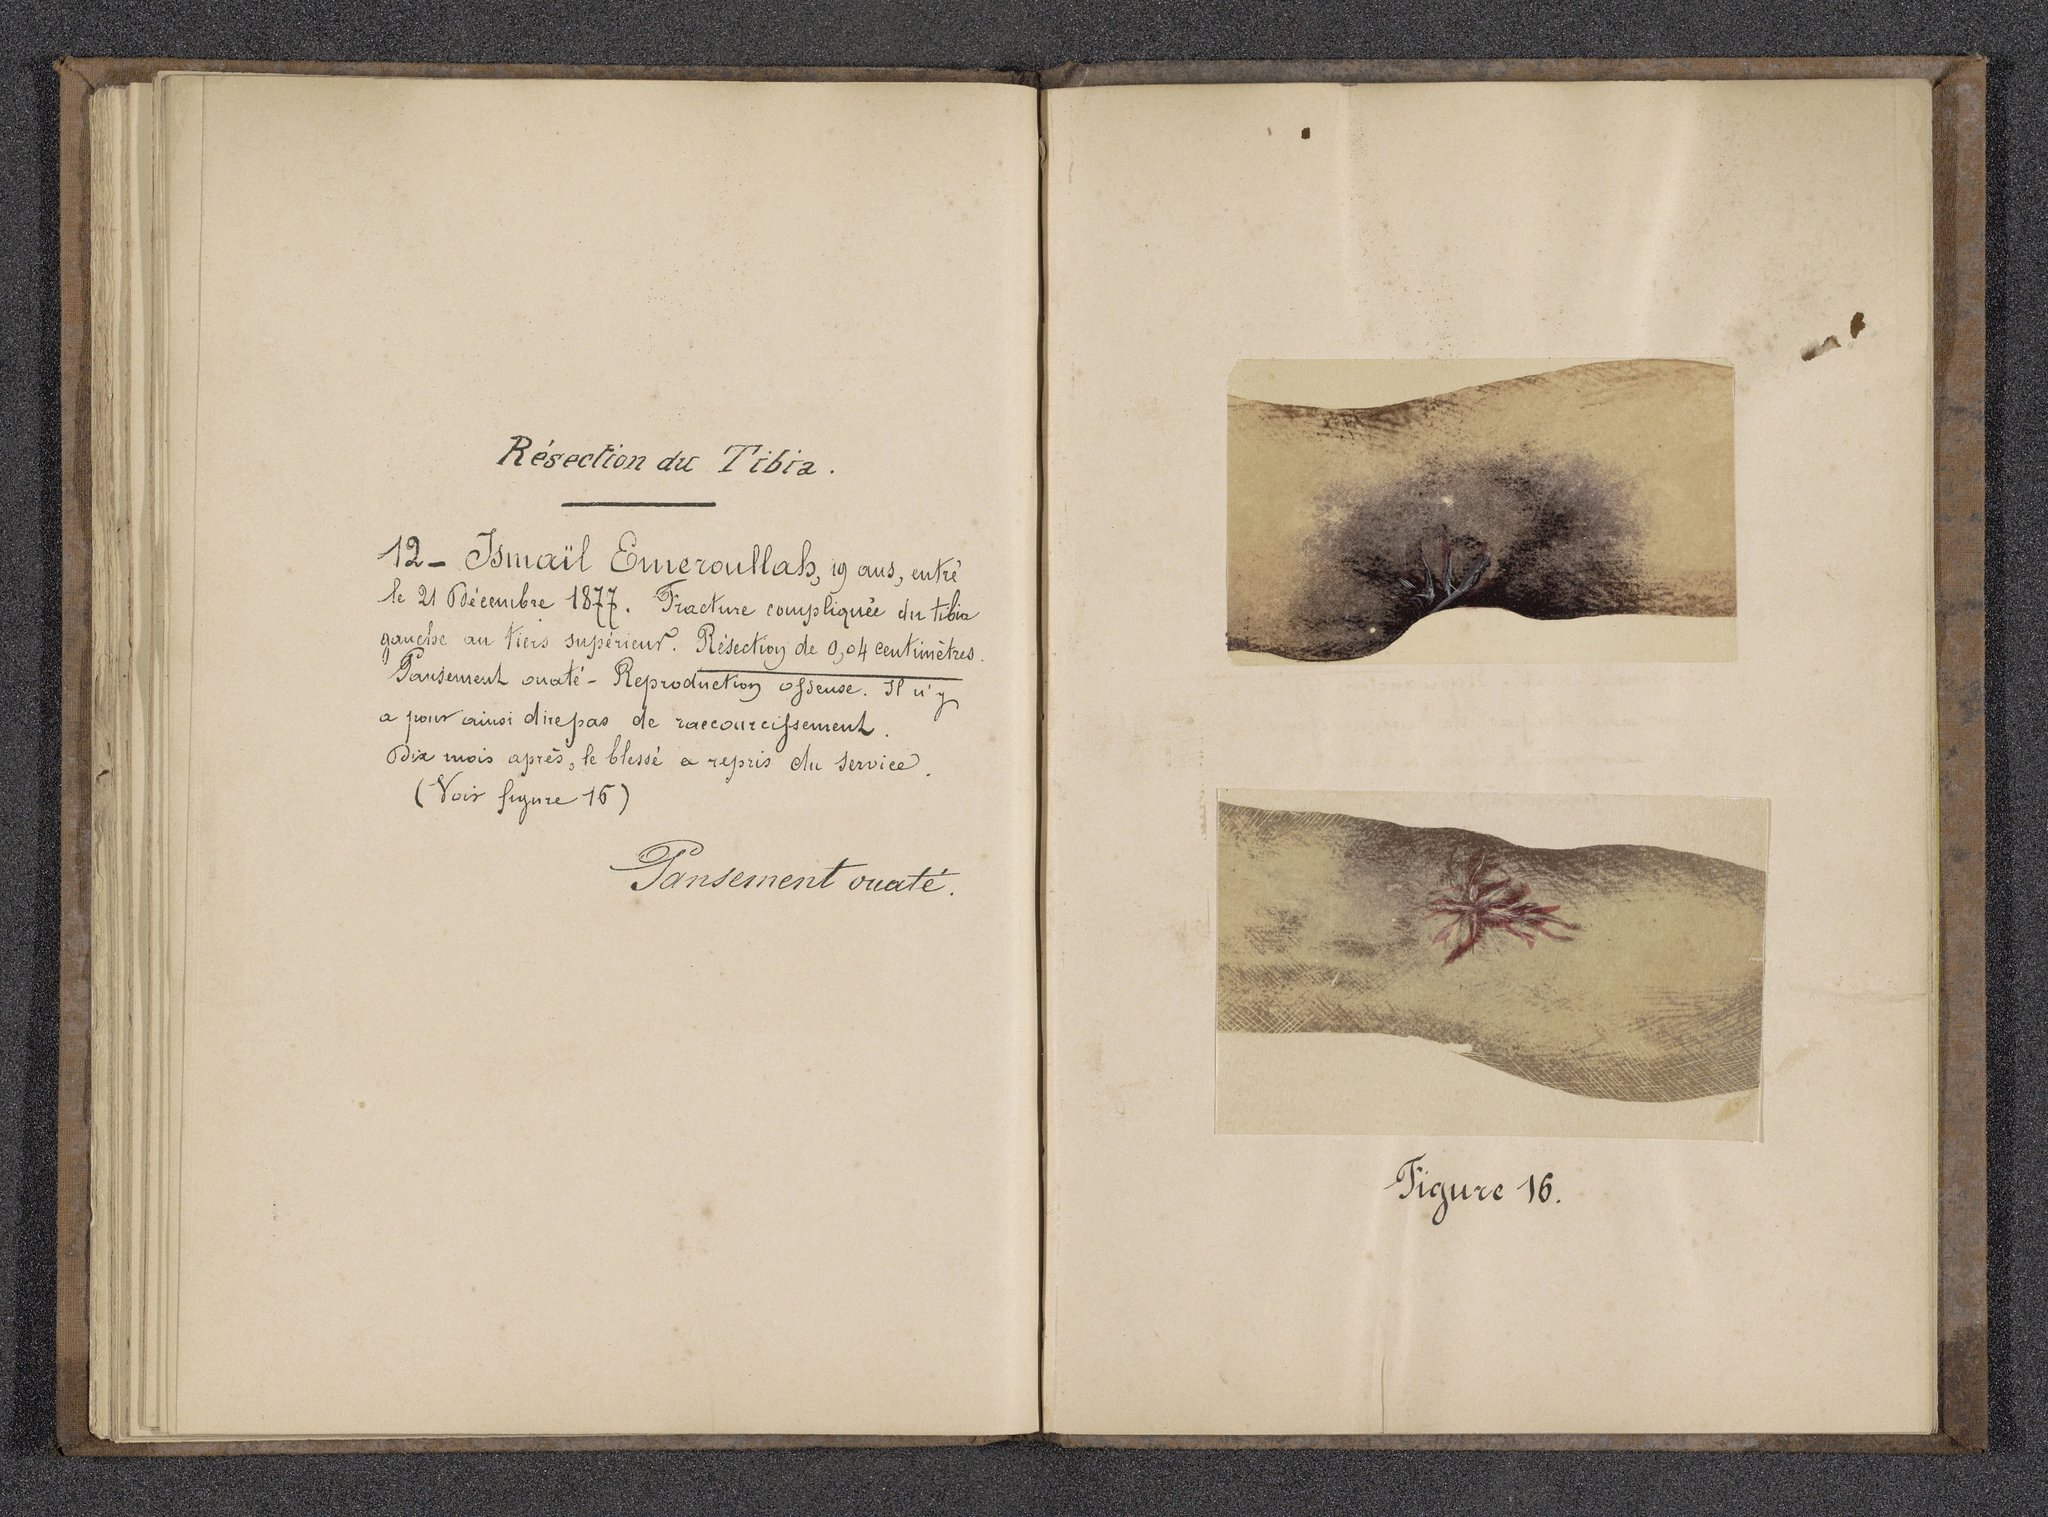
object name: reproduction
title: Twee fotoreproducties van een tekening, voorstellende de scheenbenen van Ismaïl Emeroullah na een operatie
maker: Anonymous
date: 1878-1880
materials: photographic support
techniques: albumen print, hand coloring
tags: tibia and fibula, bones of the lower leg, operation, surgery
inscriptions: number: ‘Figure 16.’